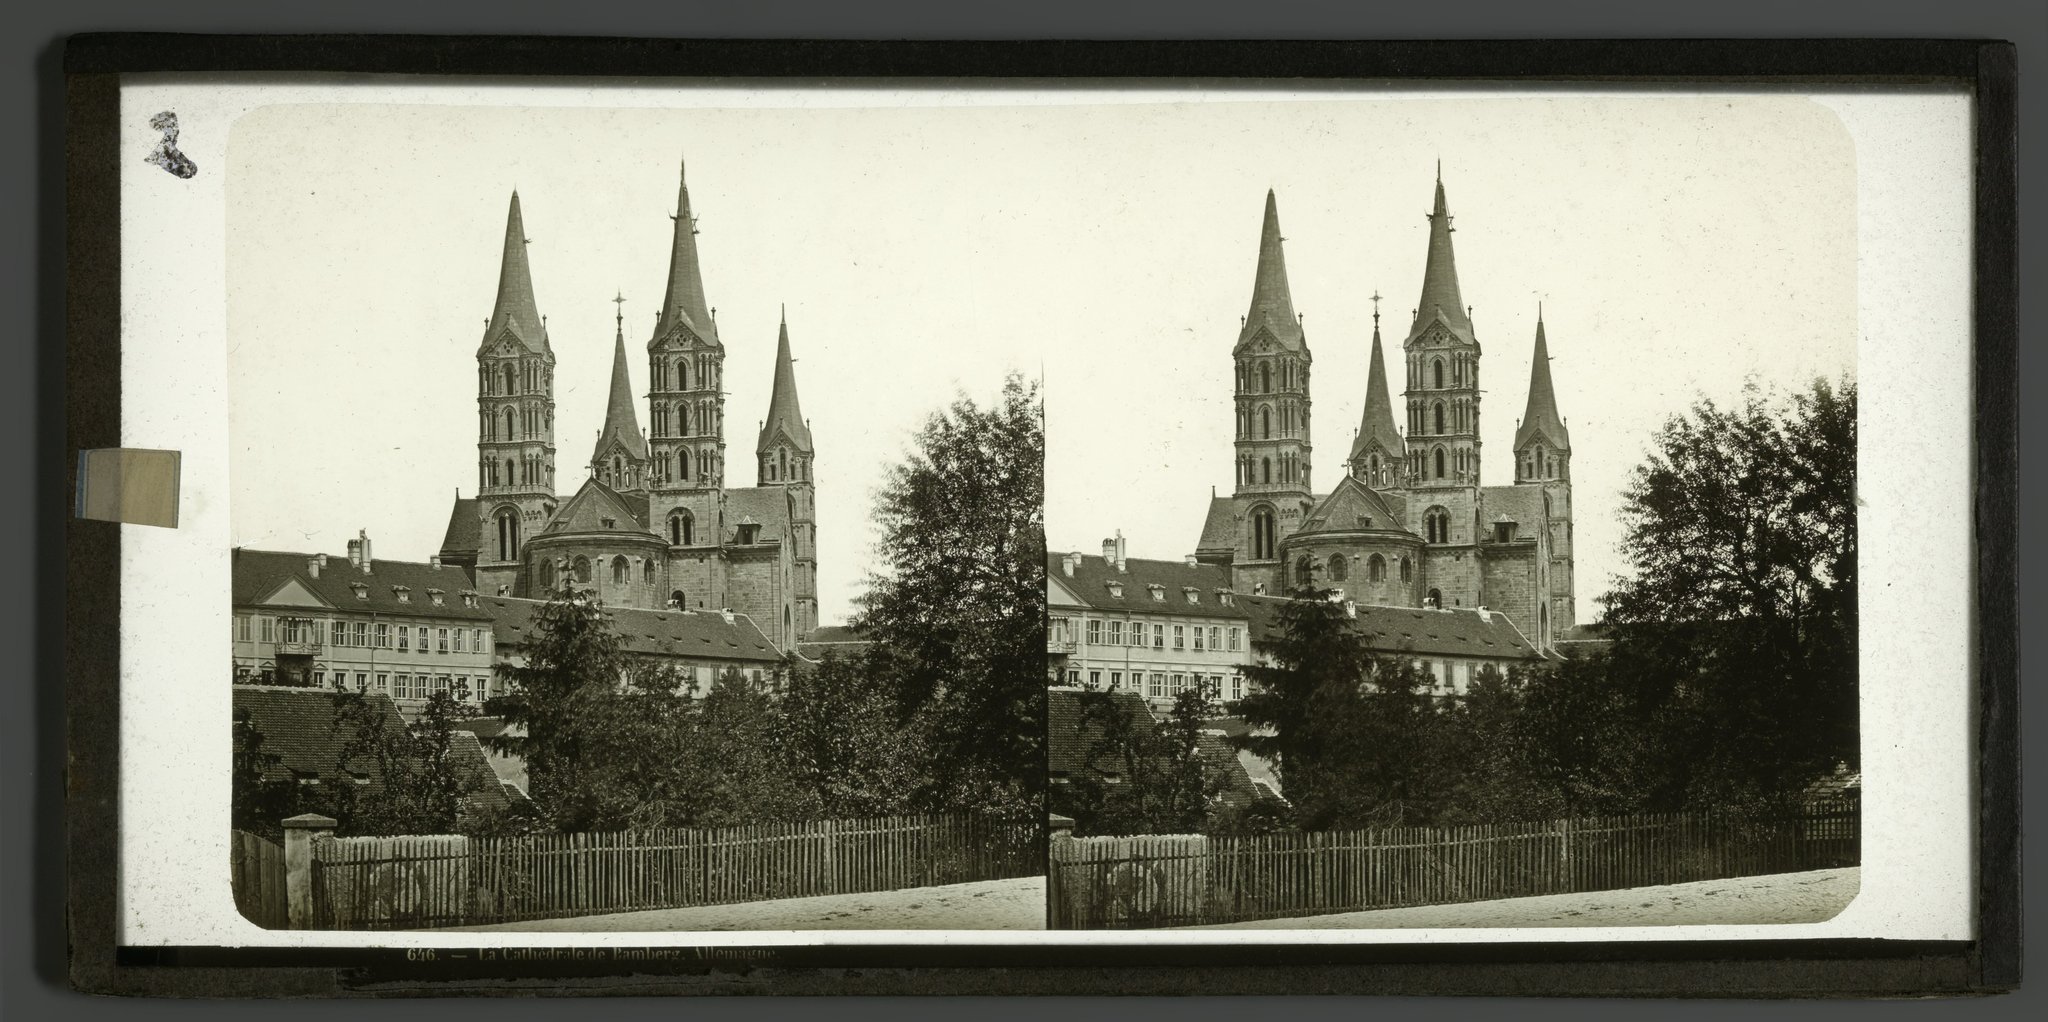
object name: stereoscopic photograph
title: La Cathédrale de Bamberg, Allemagne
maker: ferrier père-fils et soulier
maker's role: publisher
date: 1860-1890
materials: glass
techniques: slide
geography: bamberg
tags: church (exterior)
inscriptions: number: ‘2’, number: ‘646.’